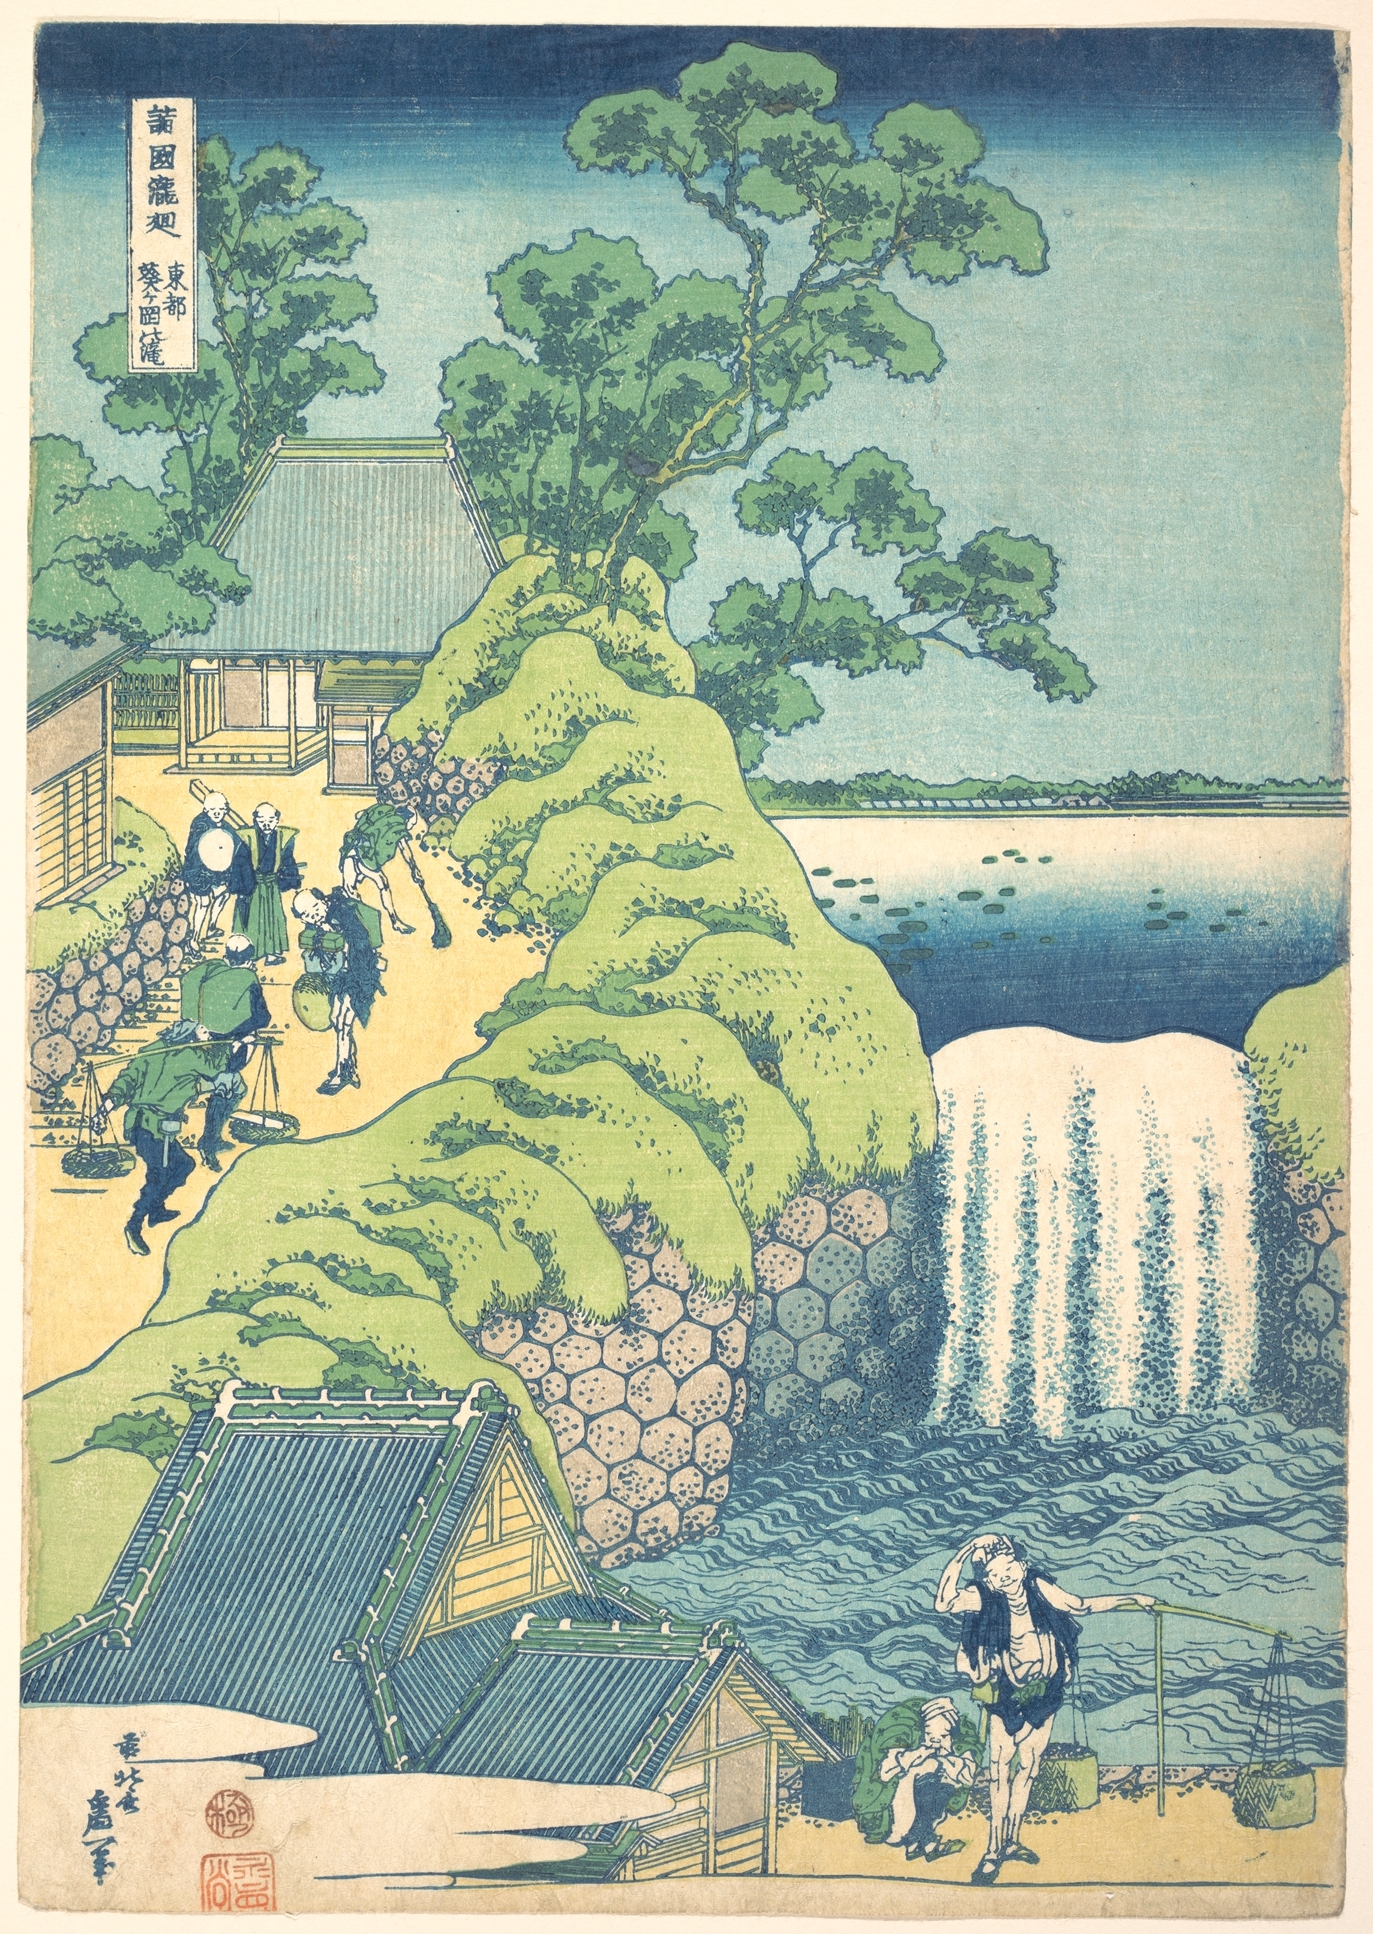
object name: woodblock print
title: The Falls at Aoigaoka in the Eastern Capital (Tōto Aoigaoka no taki), from the series A Tour of Waterfalls in Various Provinces (Shokoku taki meguri)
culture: japanese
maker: katsushika hokusai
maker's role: artist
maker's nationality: japanese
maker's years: 1760-1849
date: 1760-1849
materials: ink, paper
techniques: woodblock print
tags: houses,men,waterfalls,trees